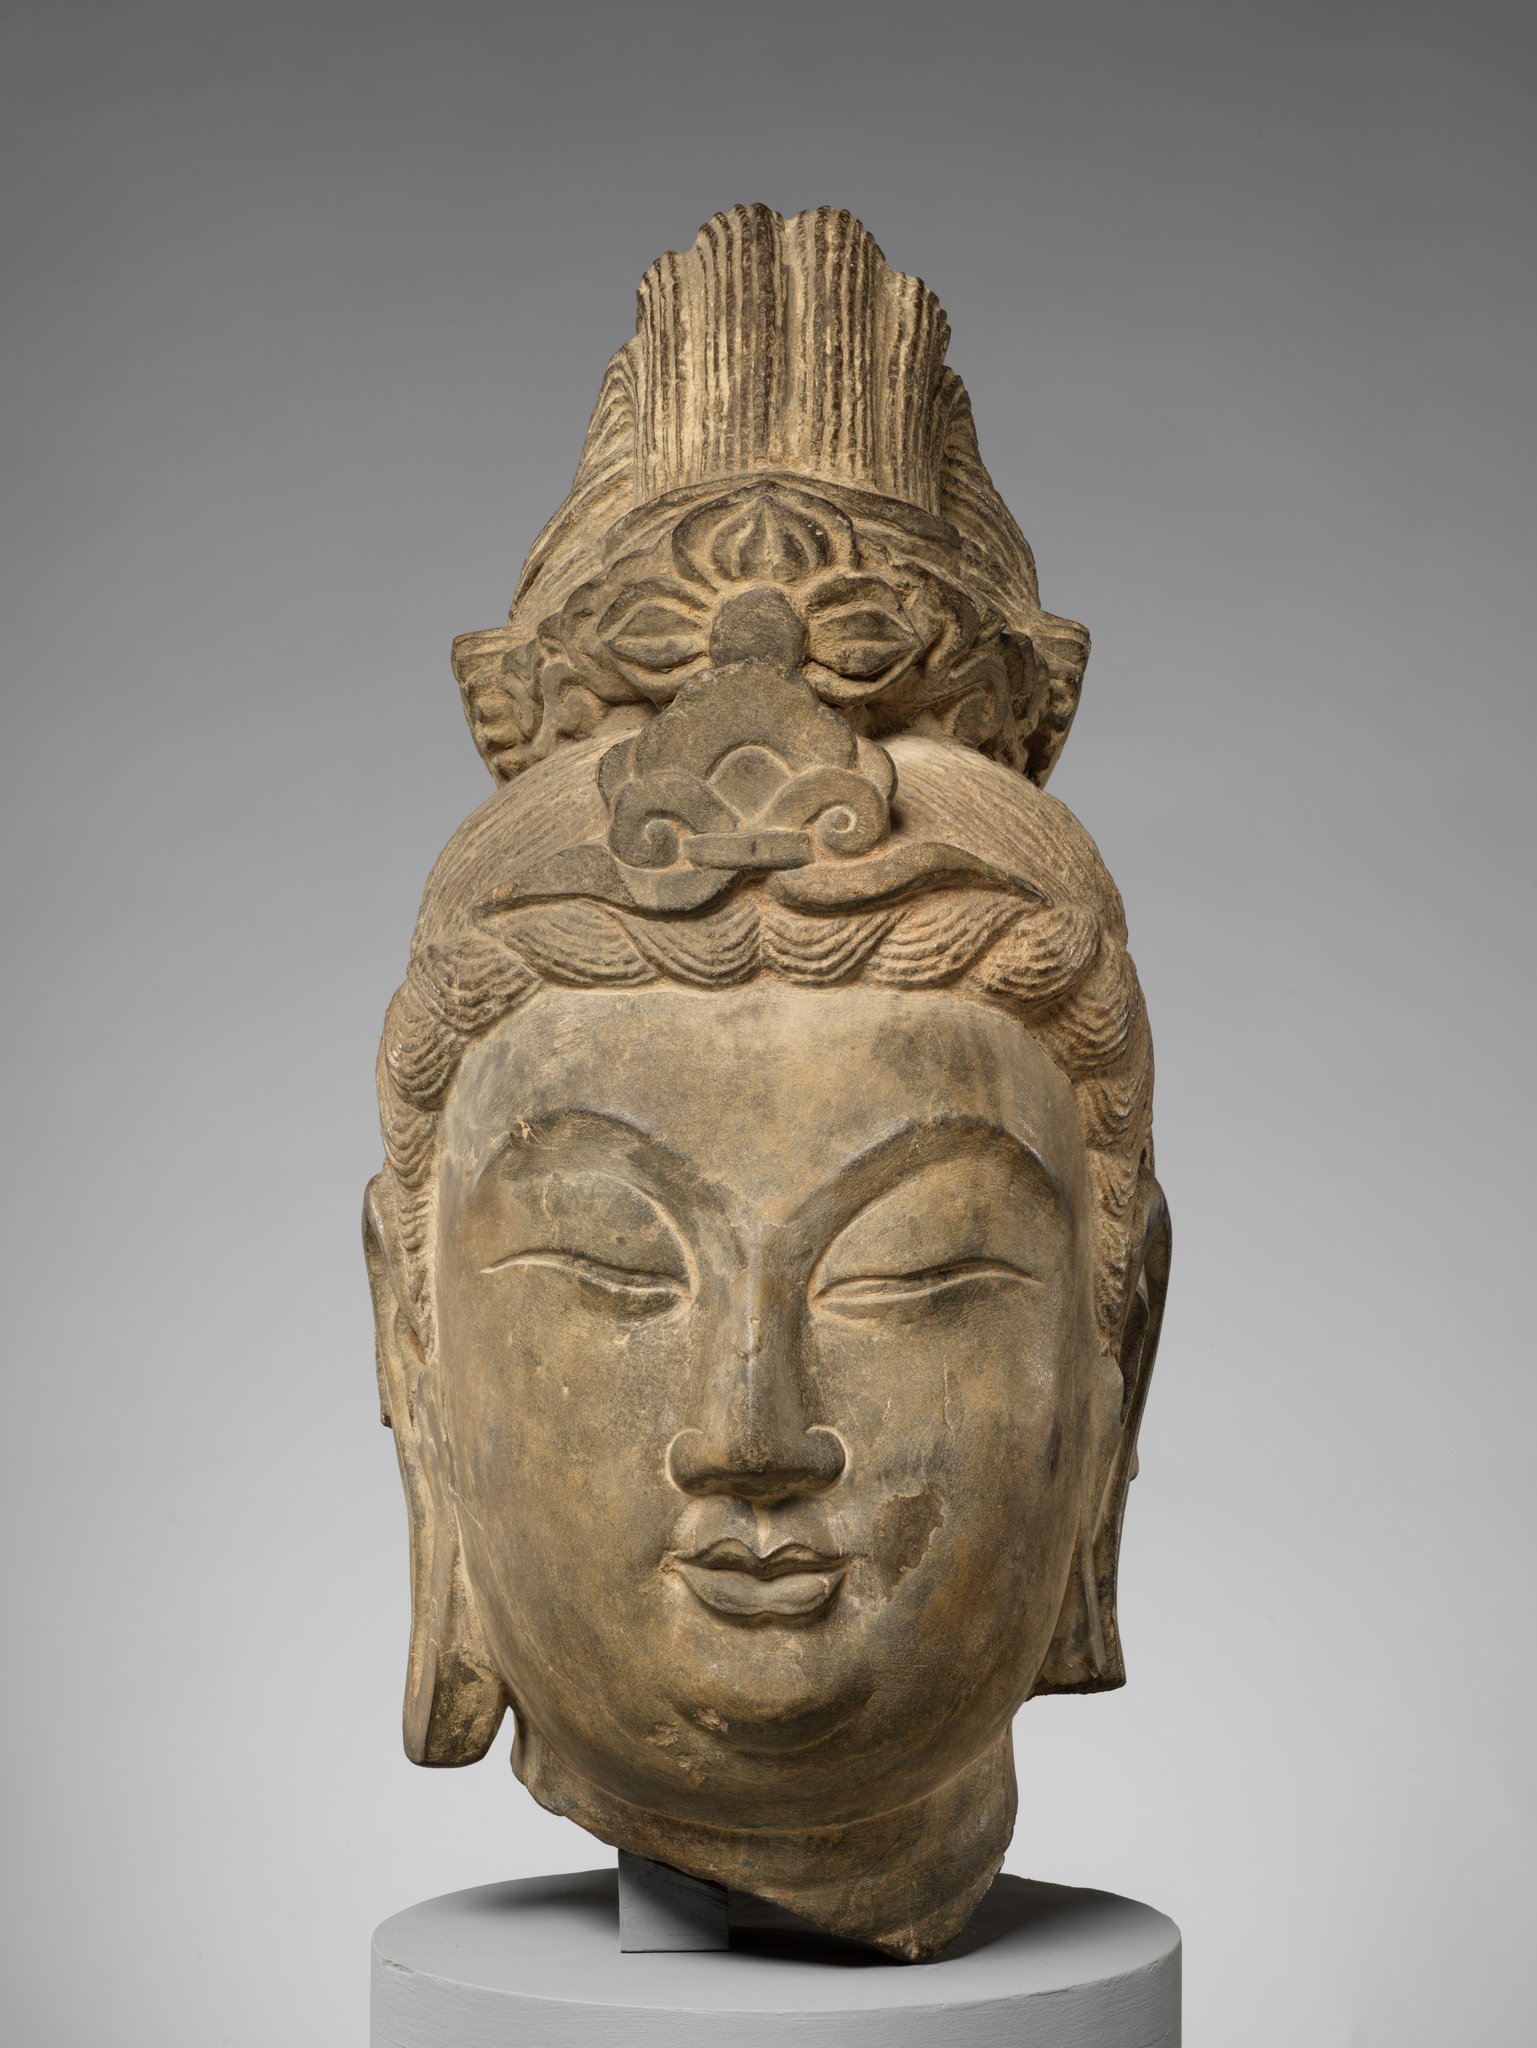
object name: head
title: Head of a bodhisattva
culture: chinese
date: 618-907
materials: stone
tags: heads,bodhisattvas